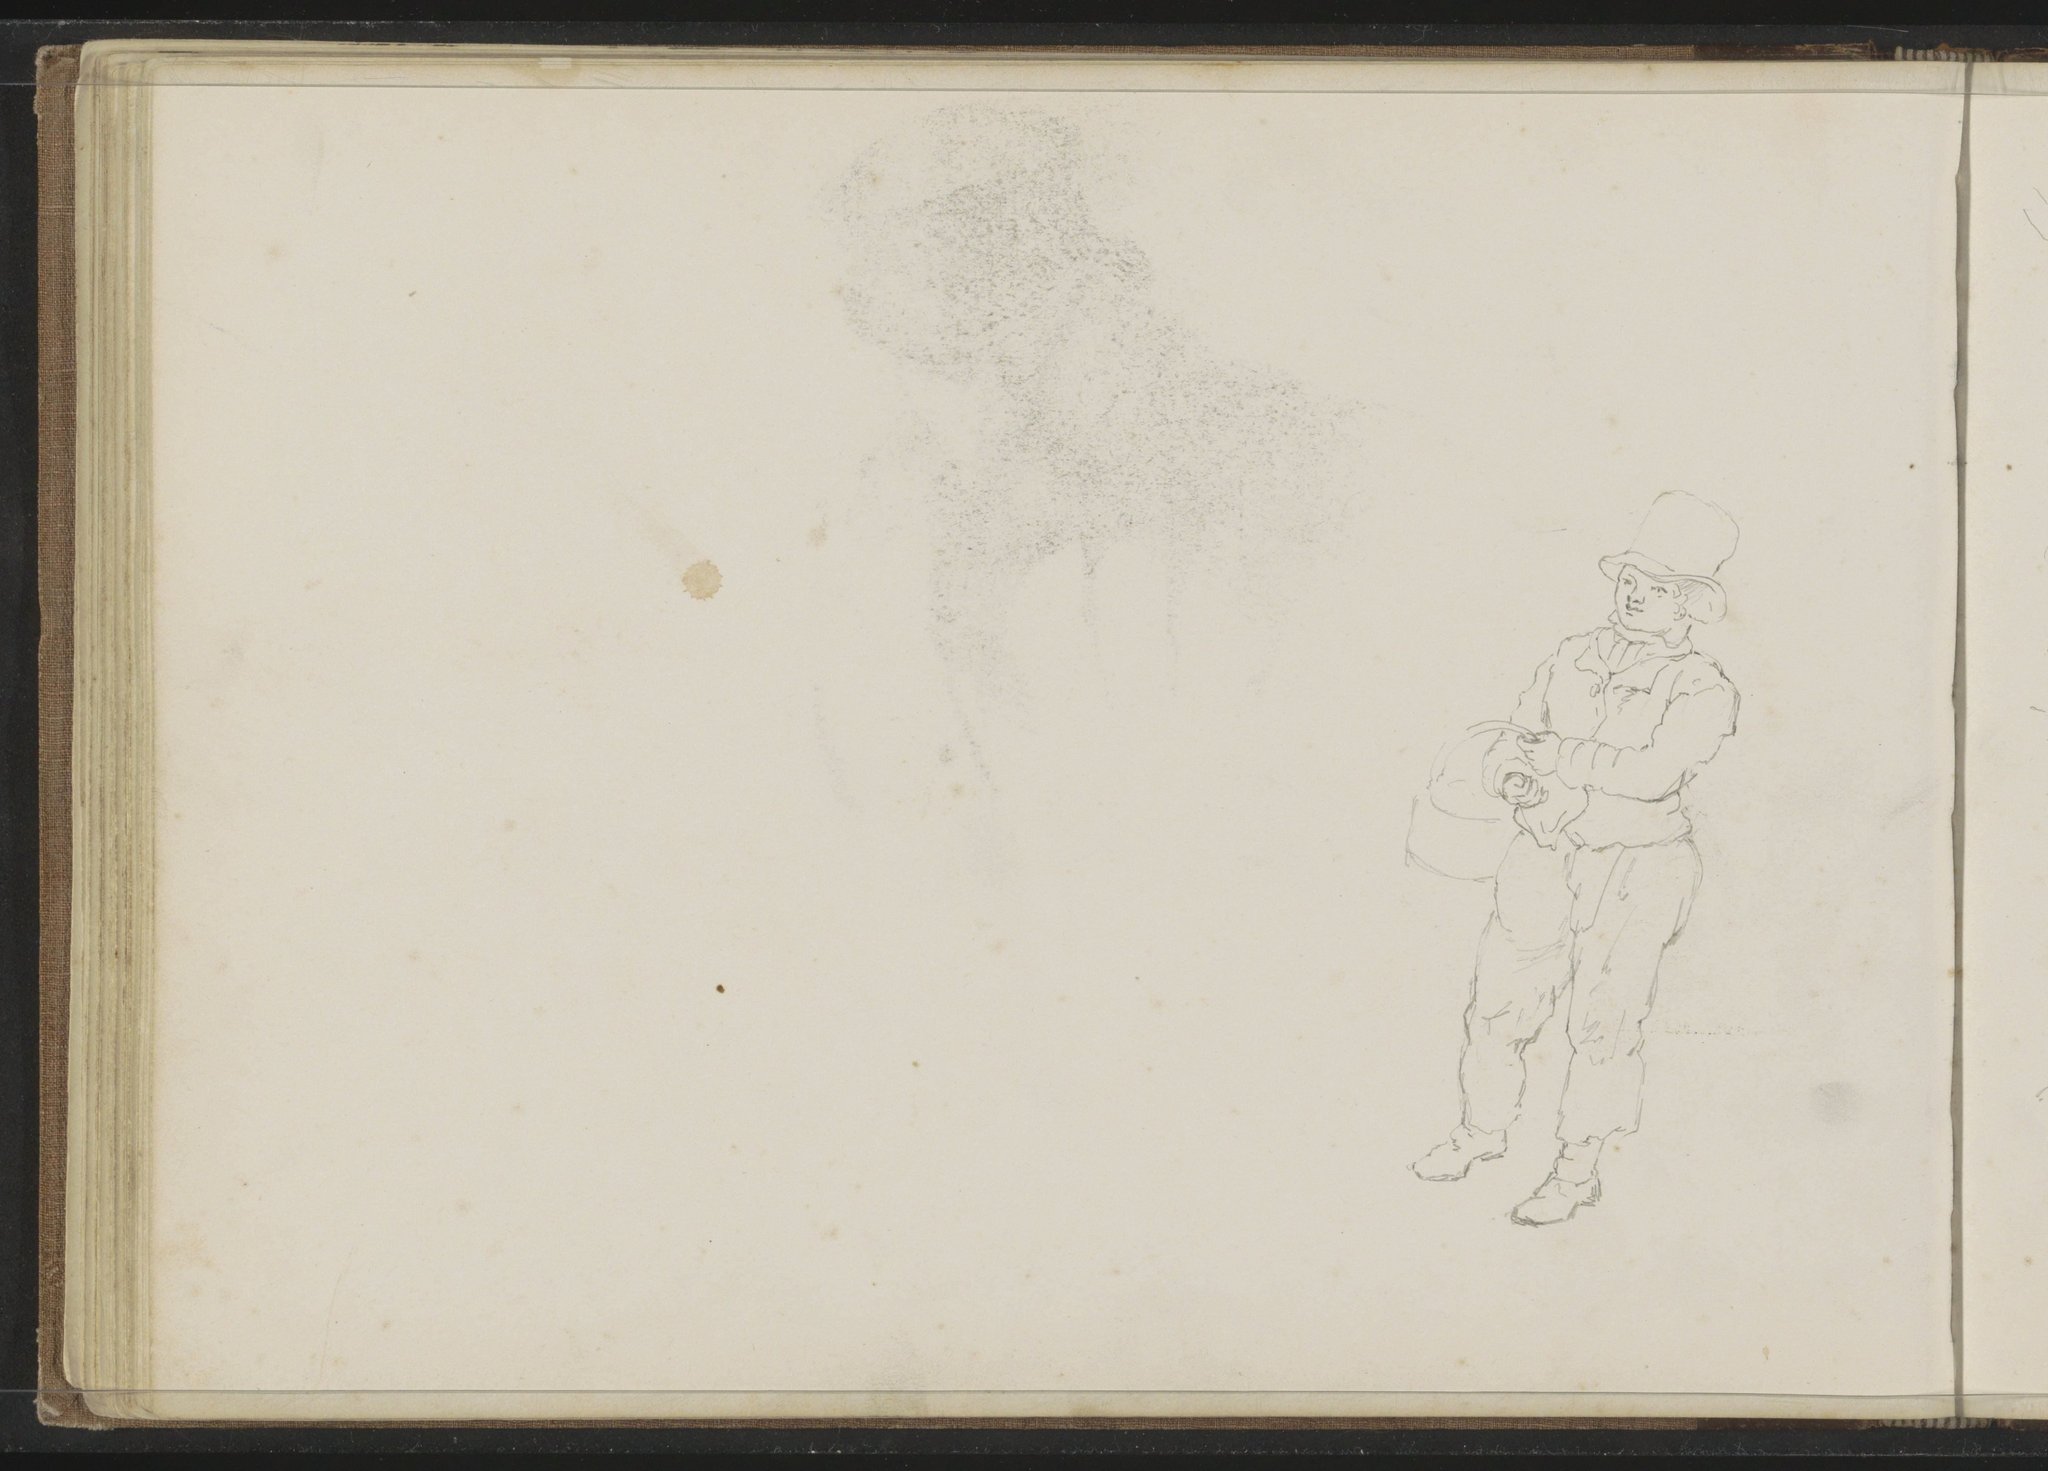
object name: sketchbook leaf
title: Jongen met een hoge hoed en mand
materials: paper, pencil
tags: boy (child between toddler and youth)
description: Blad 44 verso uit een schetsboek met 77 bladen.